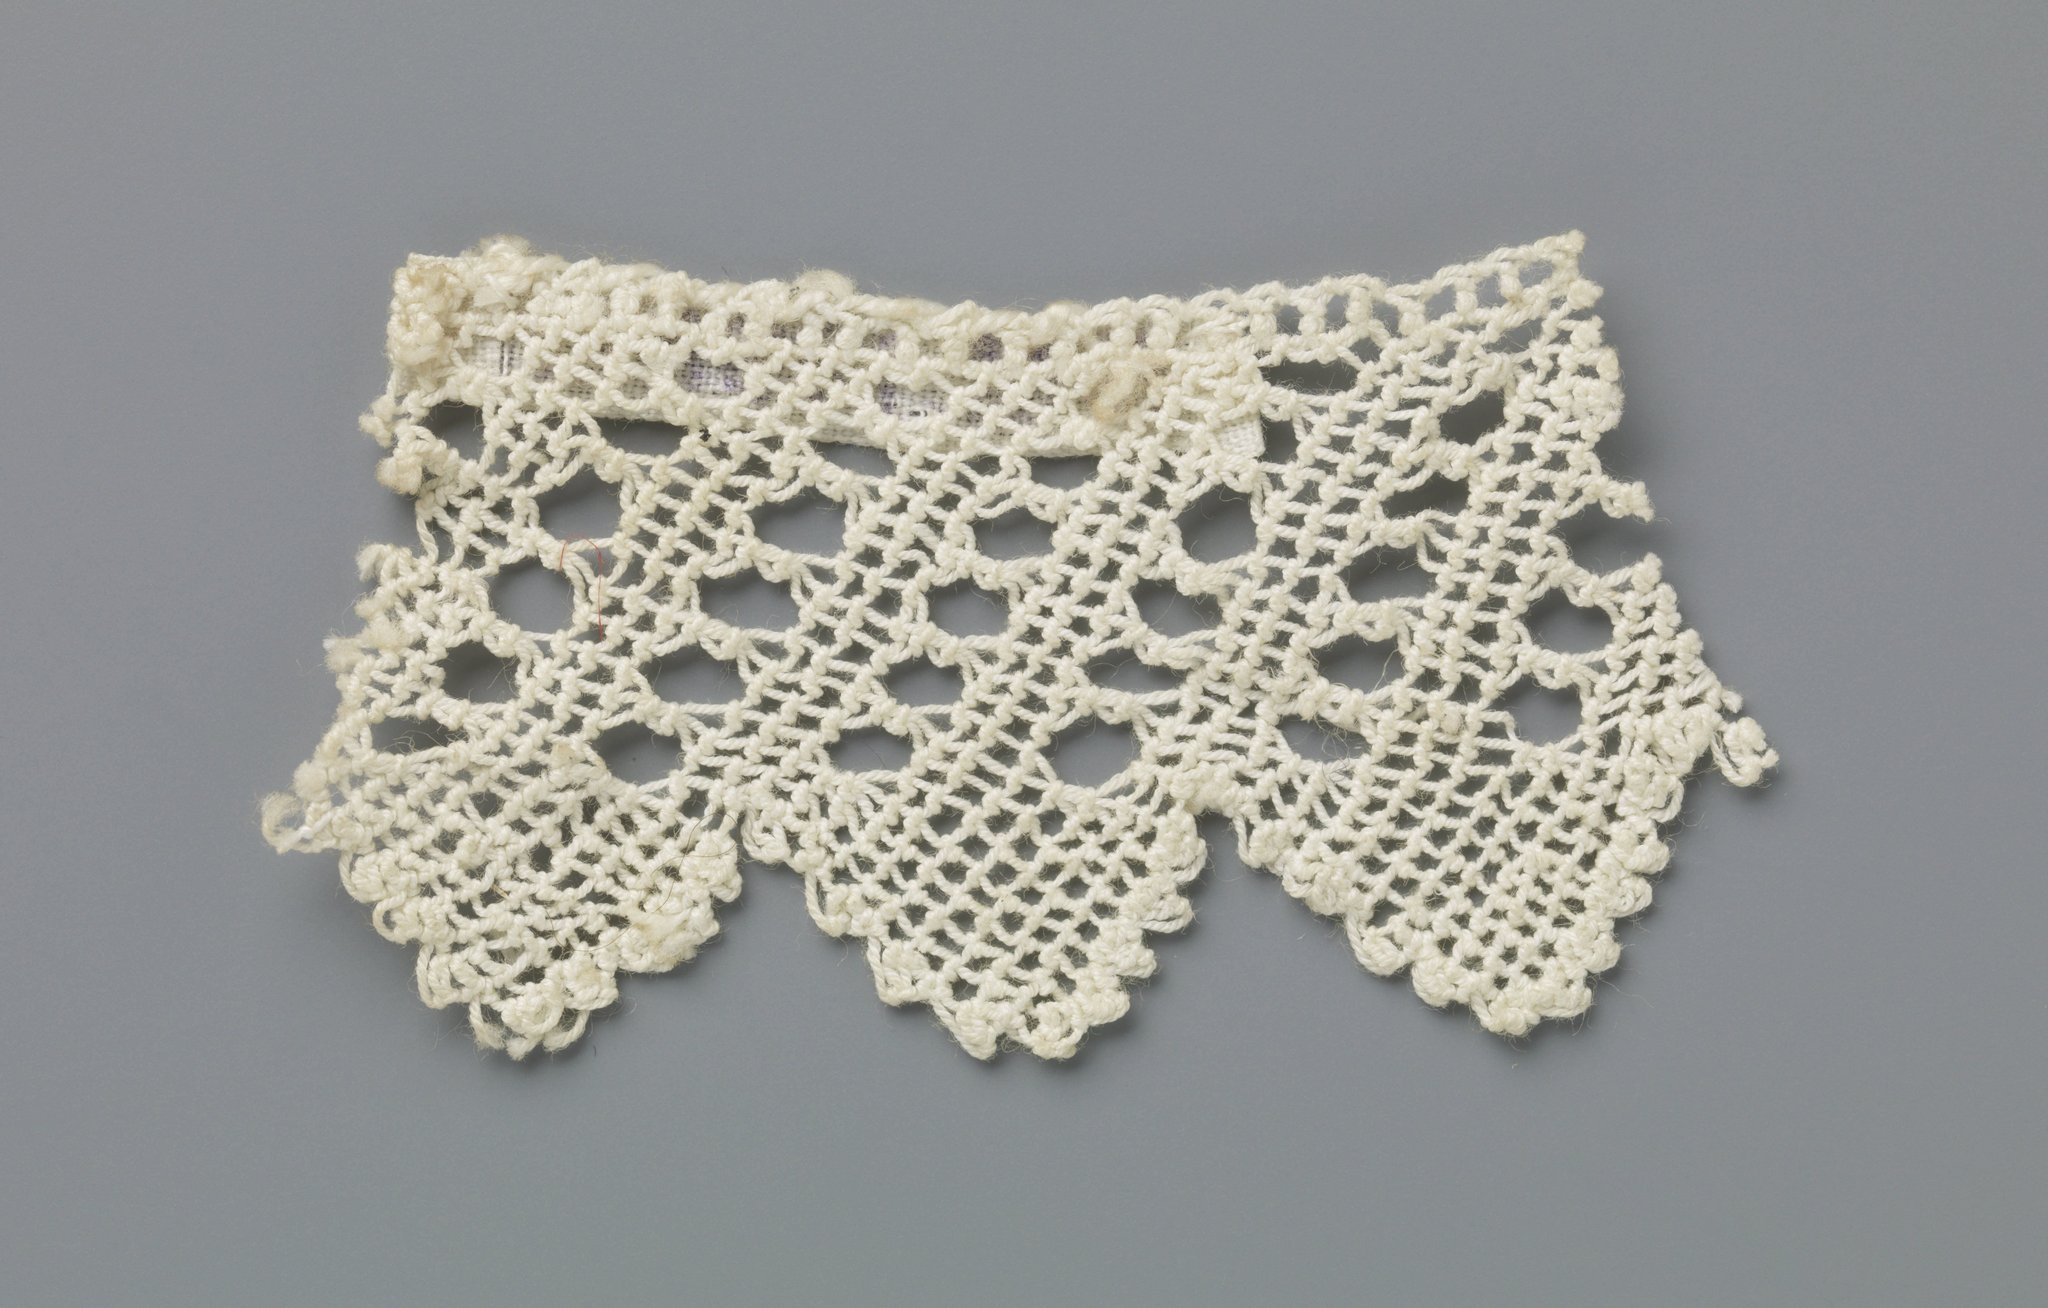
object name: strip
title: Strook geknoopt kant met schuine lijnen en schulpen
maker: Anonymous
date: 1800-1899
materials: linen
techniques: lace, knotted lace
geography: armenië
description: Strook naturelkleurige geknoopte kant: Chebka-kant. Het zich herhalende patroon bestaat uit schuine lijnen van afwisselend een fijn ruitvormig raster en opengewerkte ovaaltjes. Schulpenrand met afgeronde driehoekige schulpen. De schulpen bestaan uit hetzelfde ruitvormige raster als in het patroon daarboven. Boven elke schulp drie schuine banen. De bovenzijde van de strook is recht afgewerkt.